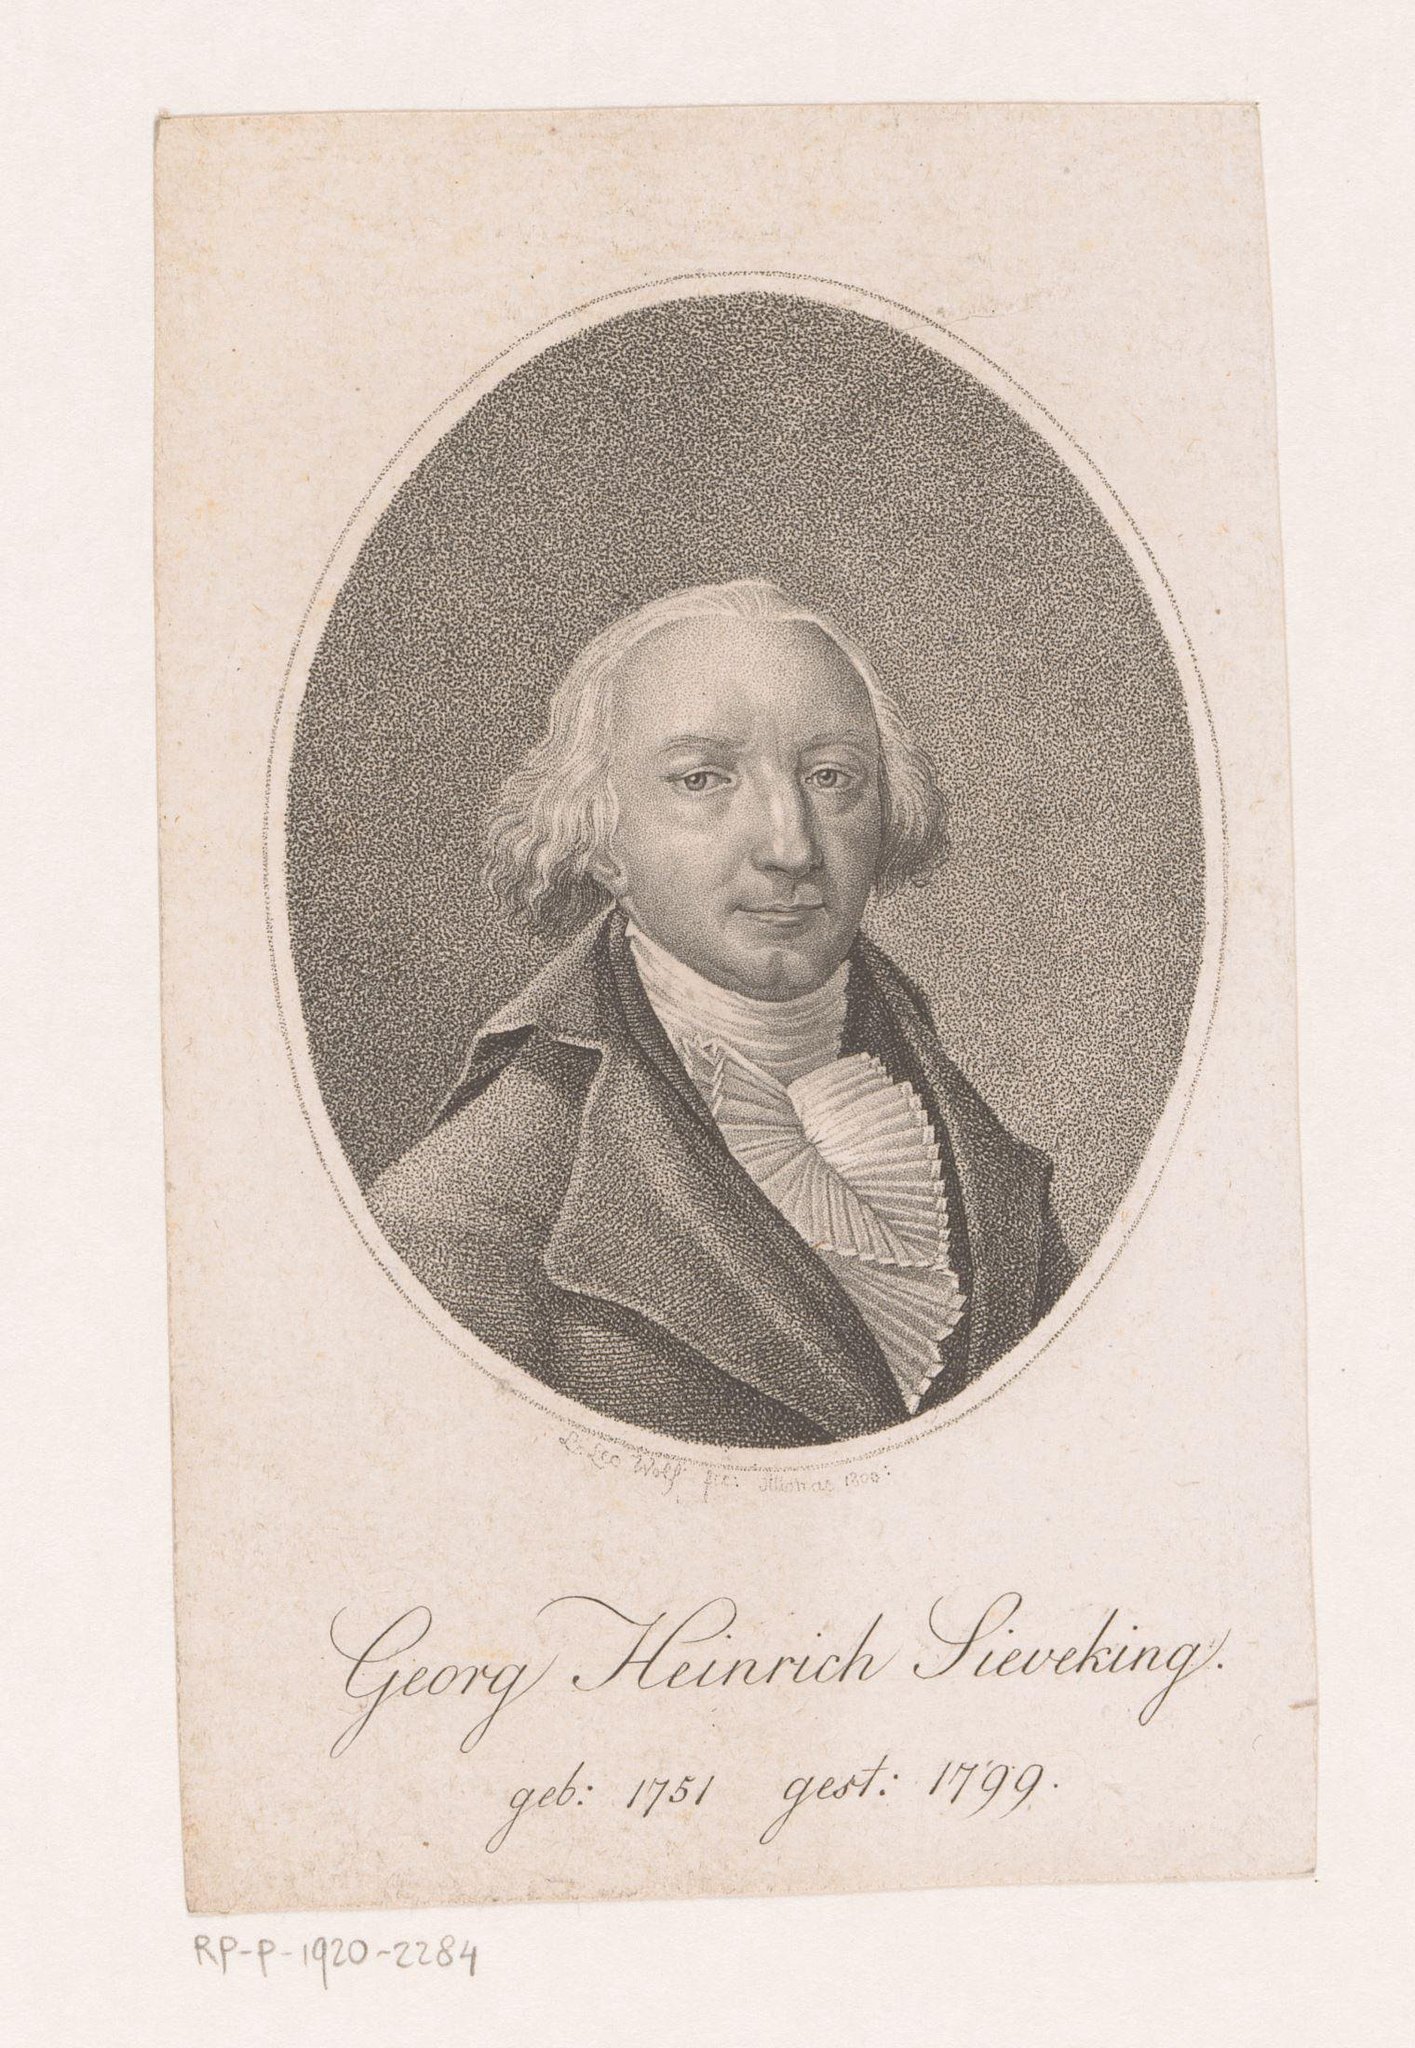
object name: print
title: Portret van Georg Heinrich Sieveking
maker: leo wolf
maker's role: draughtsman, print maker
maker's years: 1755-1840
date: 1800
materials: paper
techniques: engraving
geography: altona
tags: historical persons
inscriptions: collector's mark: Lugt 2228